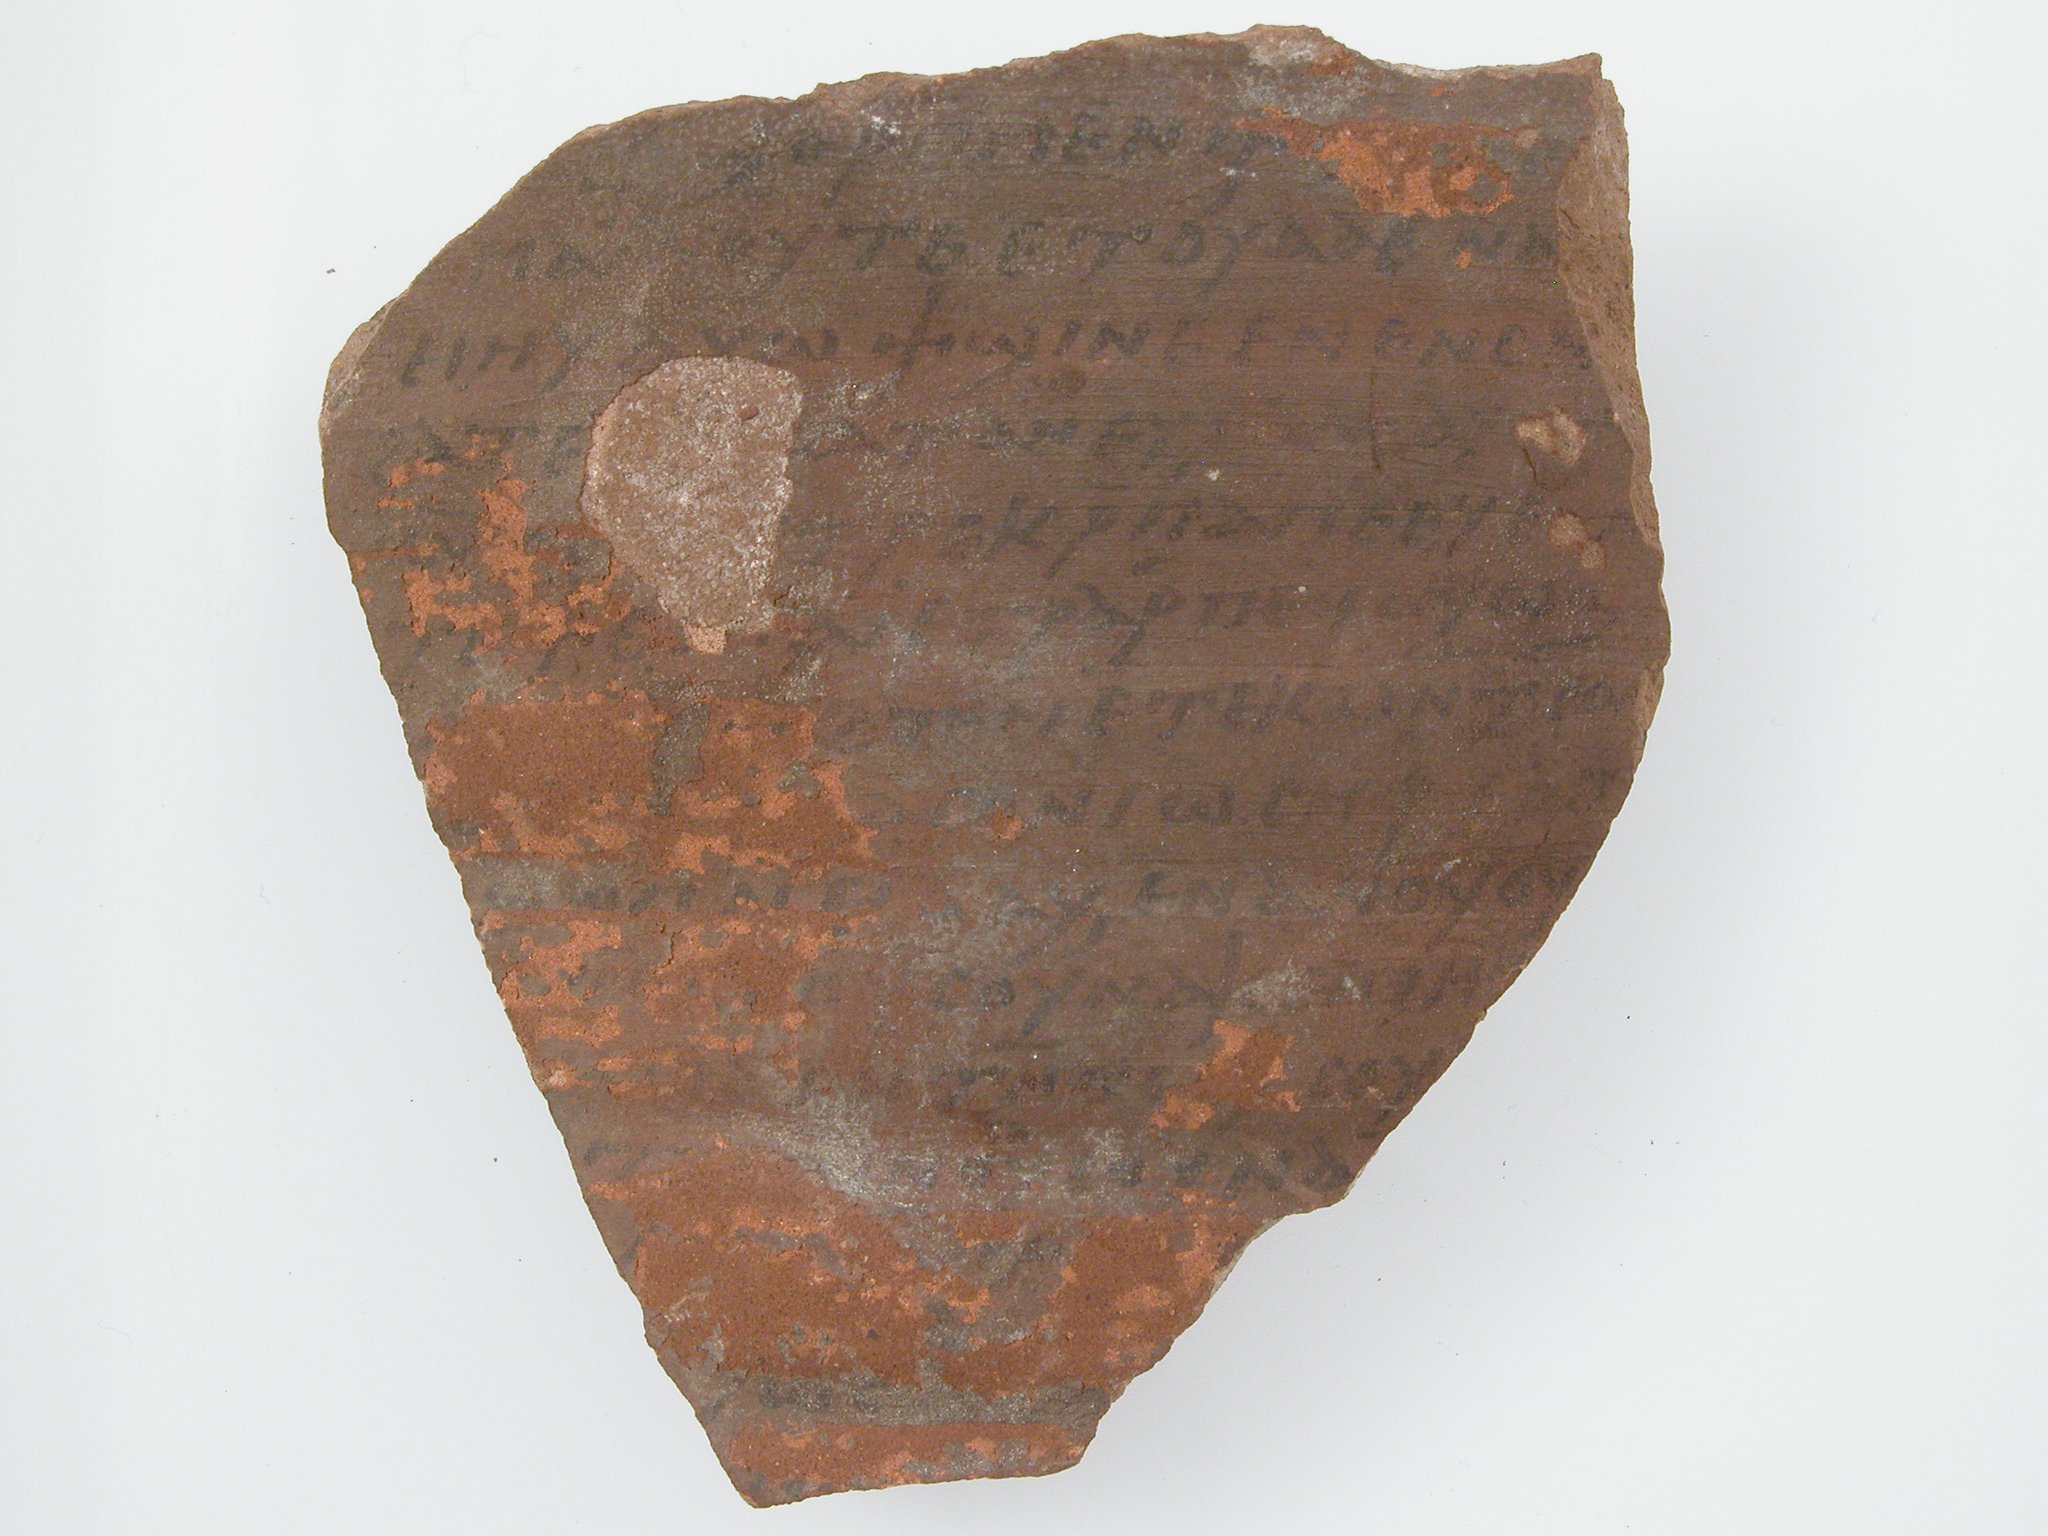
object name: ostrakon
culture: coptic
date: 580-640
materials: ink, pottery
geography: egypt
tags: coptic,documents